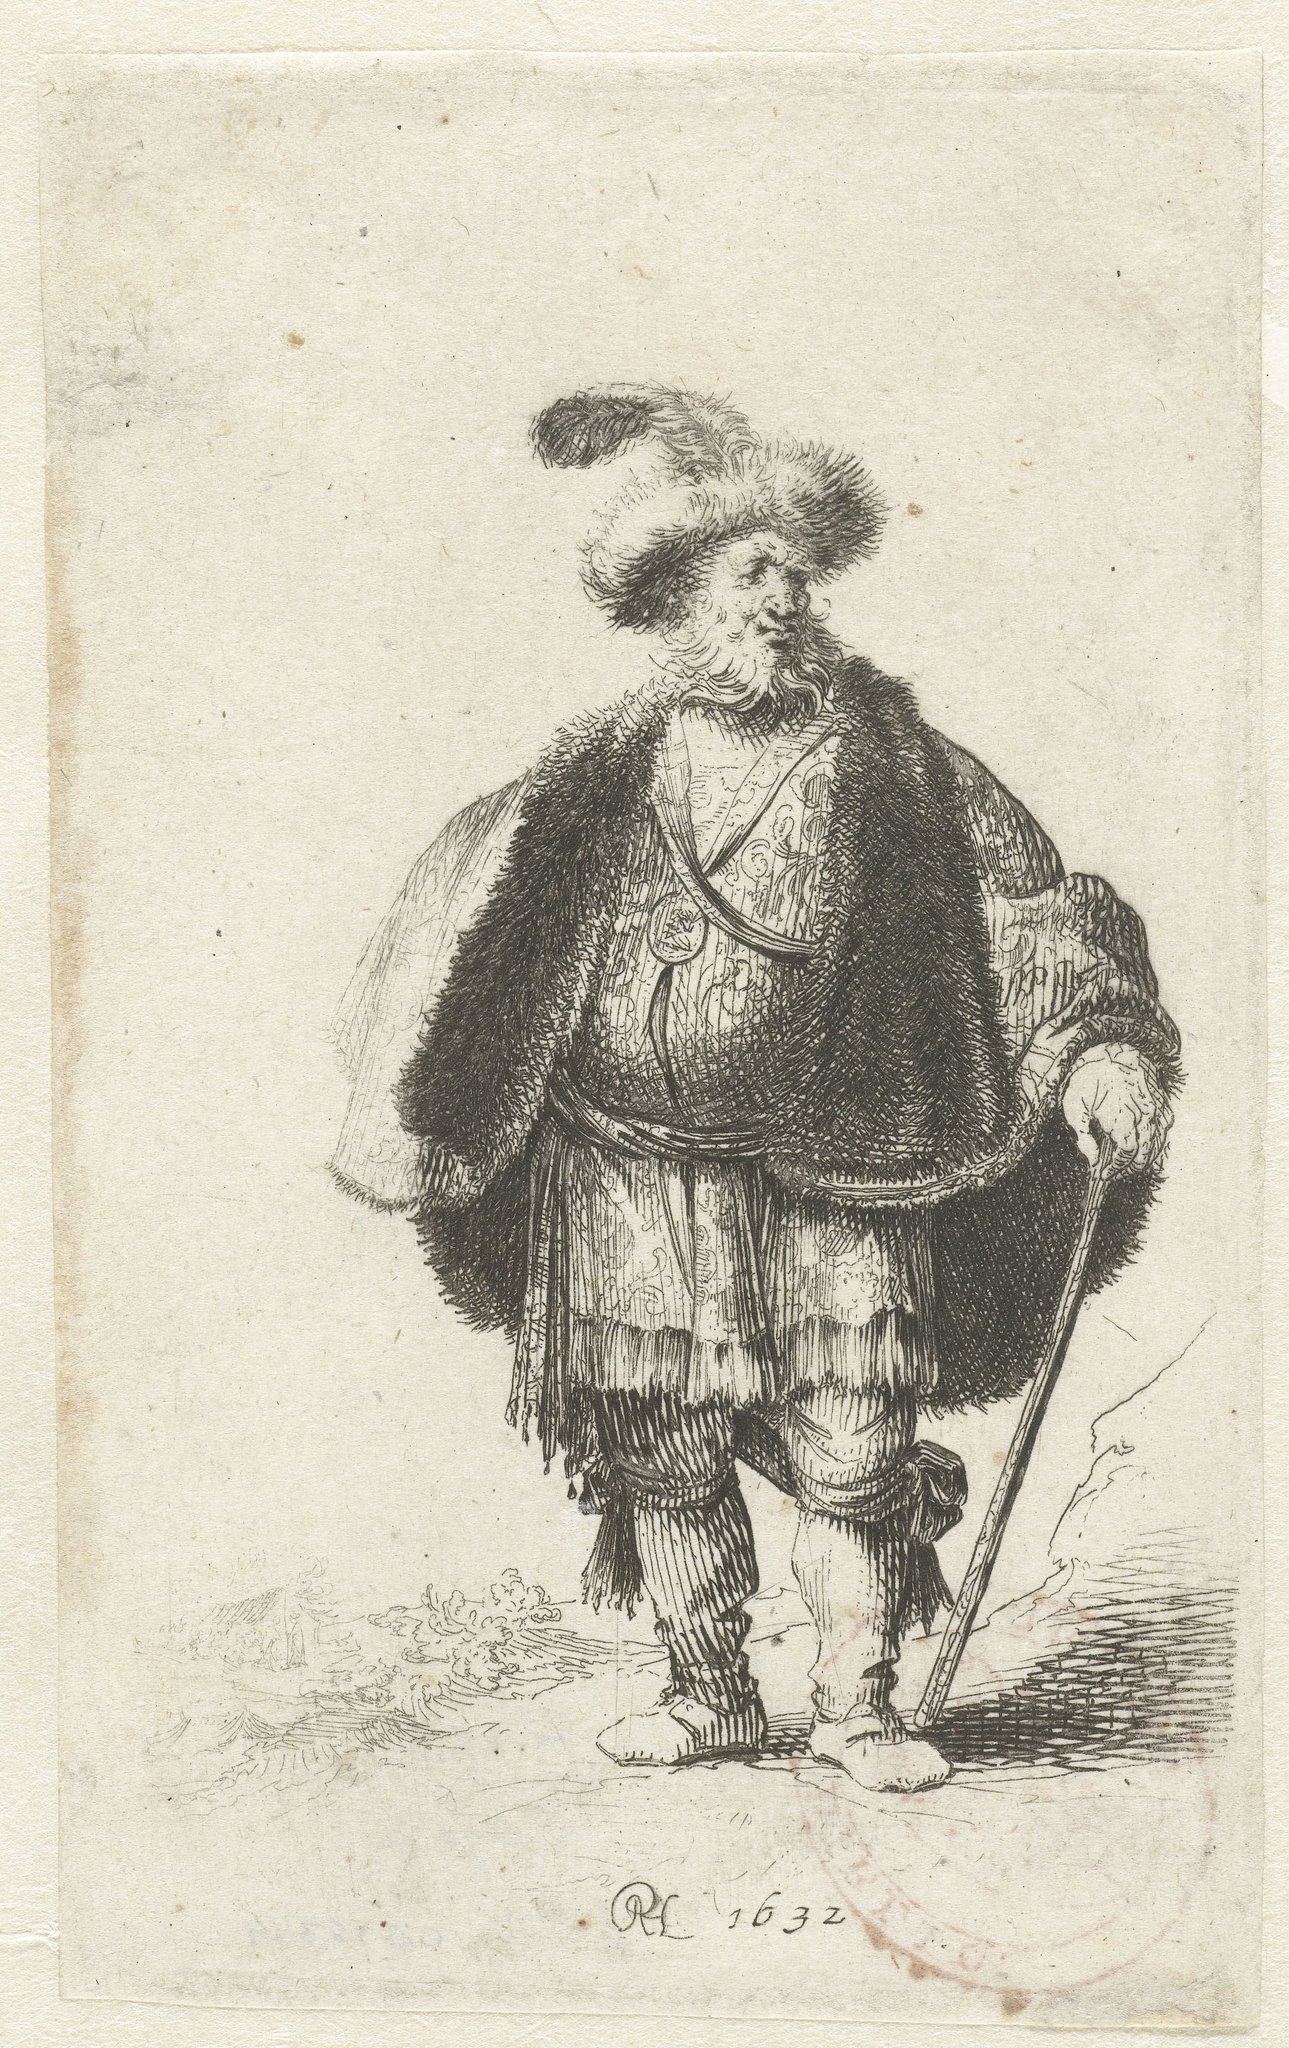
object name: print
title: The Persian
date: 1632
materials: paper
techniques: etching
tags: asiatic races and peoples: persians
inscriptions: collector's mark: Lugt 240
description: Spiegelbeeldige kopie naar de gelijknamige prent van Rembrandt.